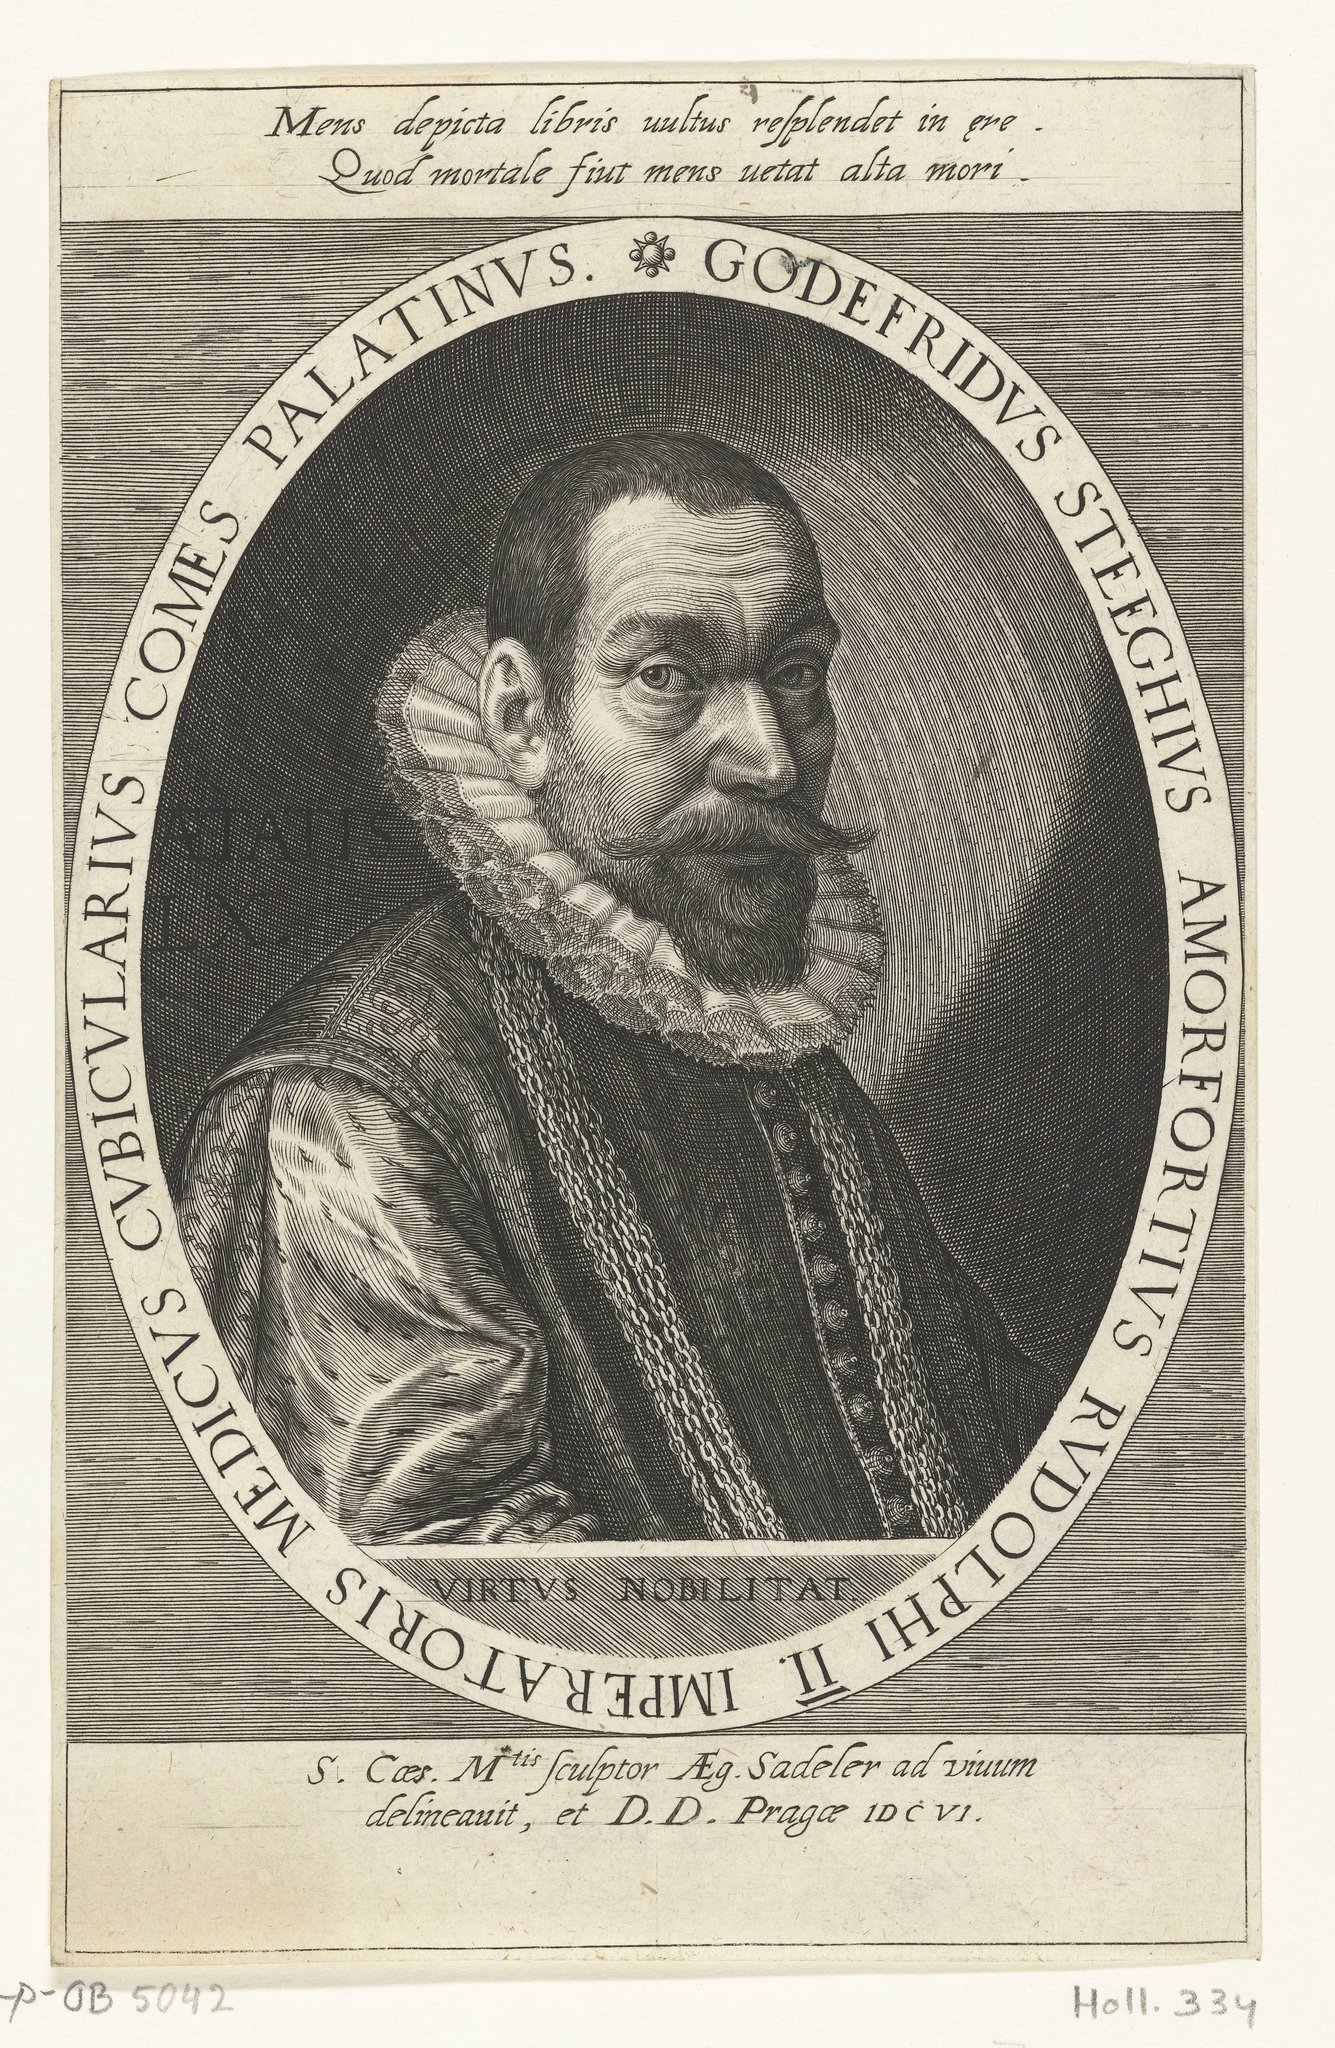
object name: print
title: Portret van Godfried Steeghius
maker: aegidius sadeler (ii)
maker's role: draughtsman, print maker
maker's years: 1568-1629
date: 1606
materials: paper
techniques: engraving, etching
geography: prague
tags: amersfoort, arts, godfried steeghius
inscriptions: collector's mark: Lugt 240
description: Godfried Steeghius, lijfarts van de keizer Ferdinand I, Maximiliaan II en Rudolf II, op 60-jarige leeftijd.